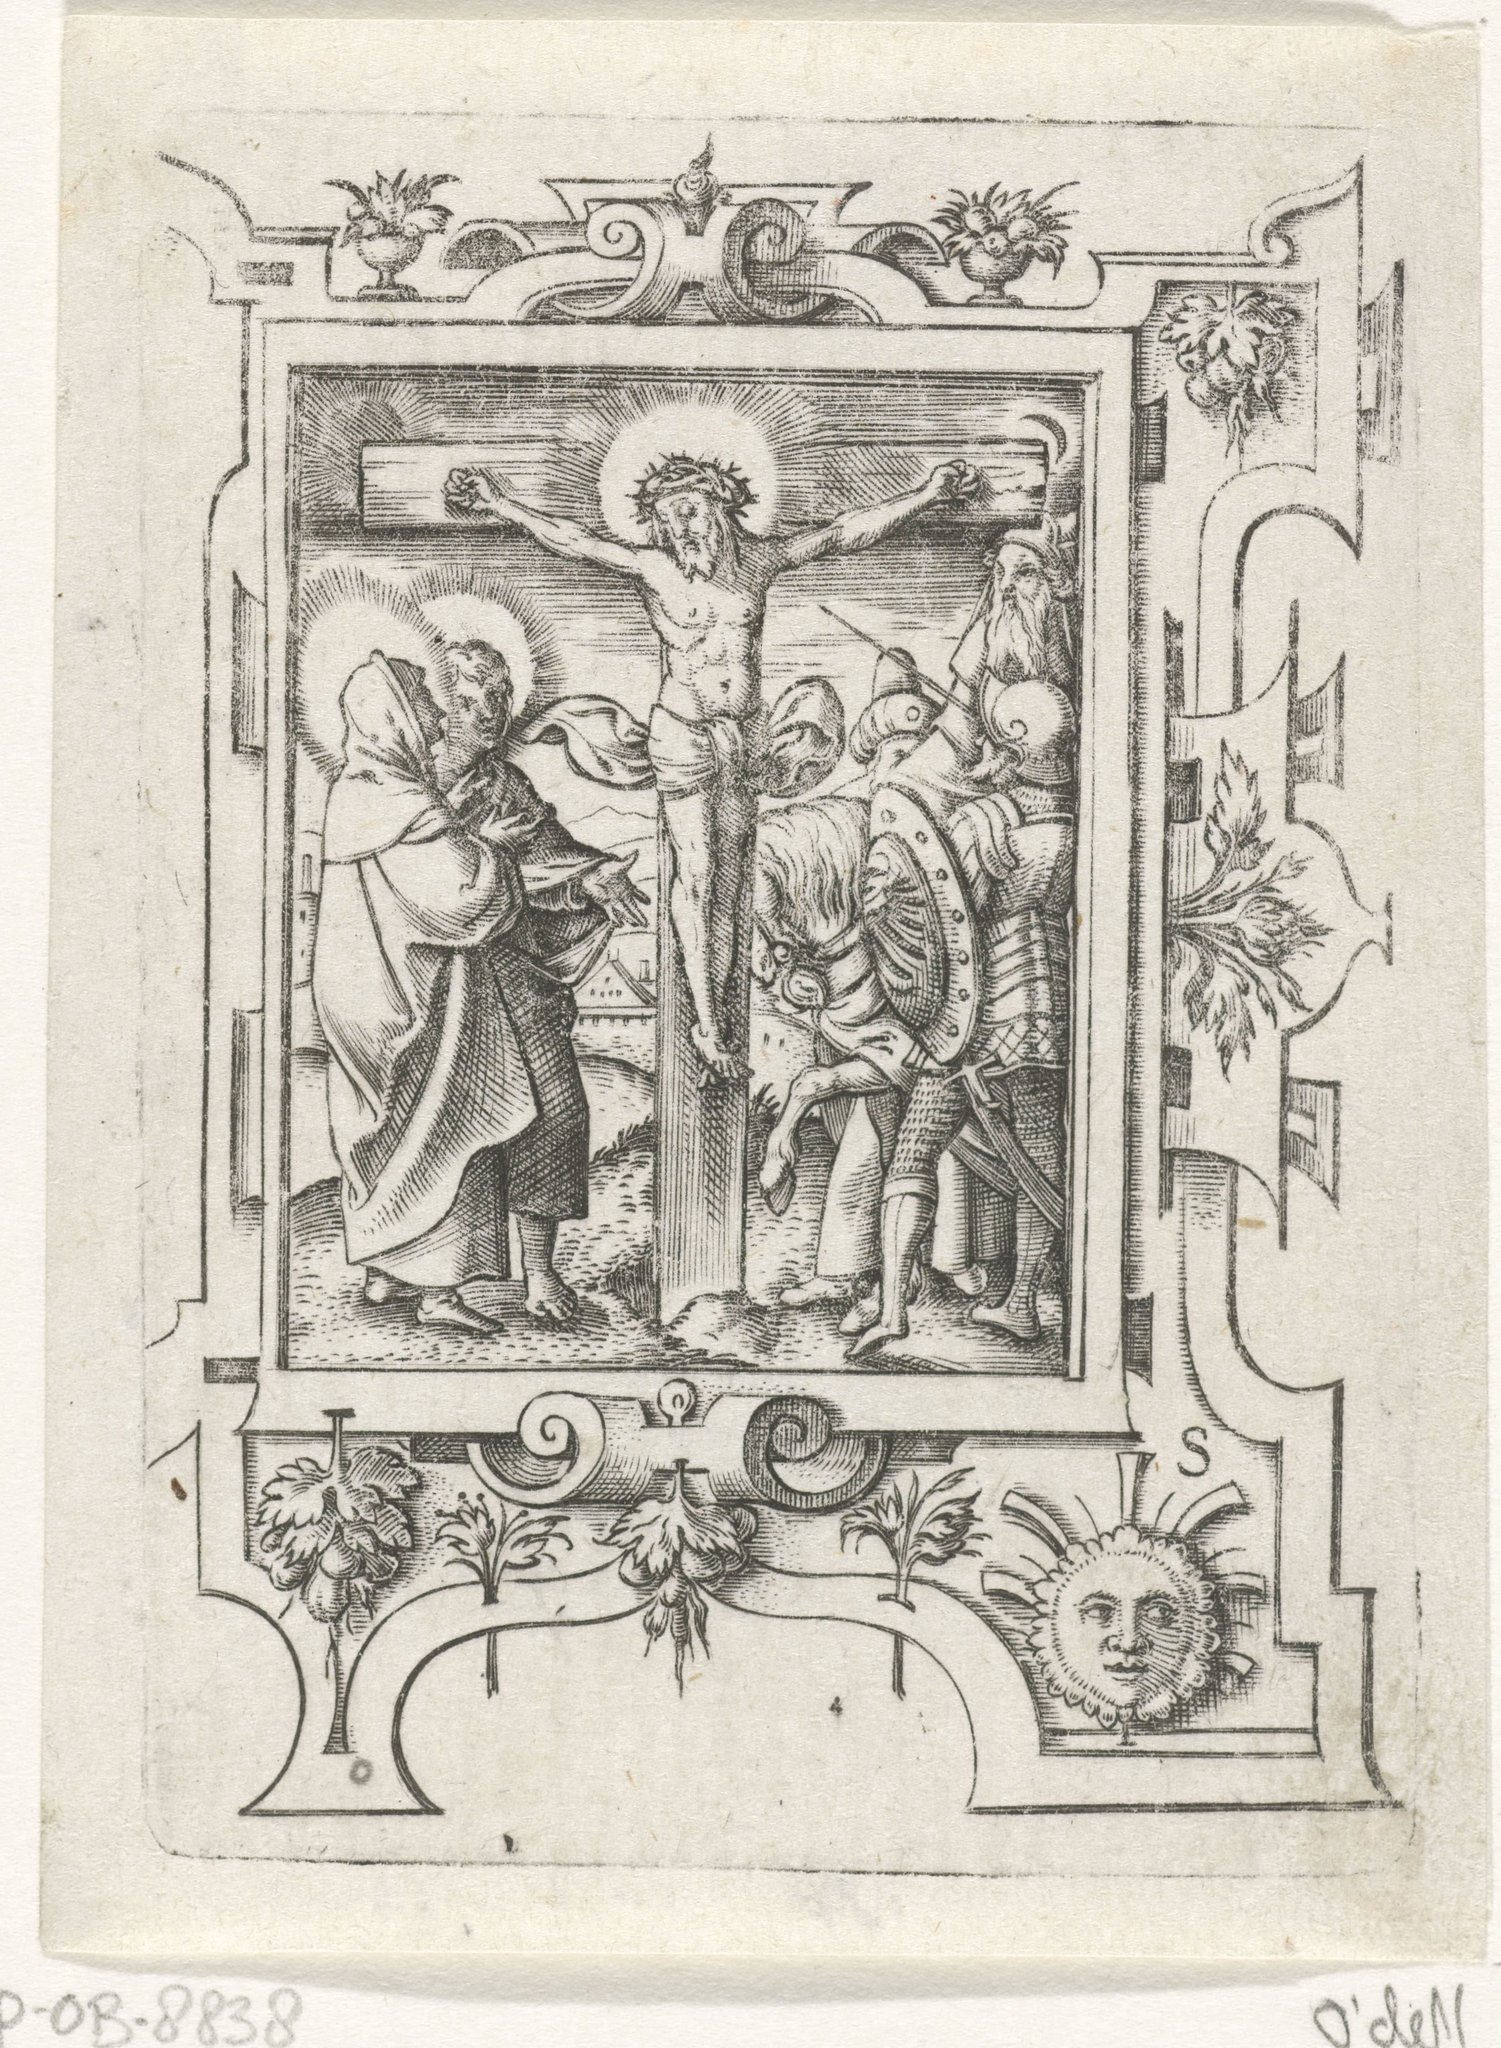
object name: print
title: De Kruisiging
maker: virgilius solis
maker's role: draughtsman, print maker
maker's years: 1514-1562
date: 1524-1562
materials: paper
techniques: engraving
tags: the crucifixion of christ: christ's death on the cross; golgotha (matthew 27:45-58; mark 15:33-45; luke 23:44-52; john 19:25-38)